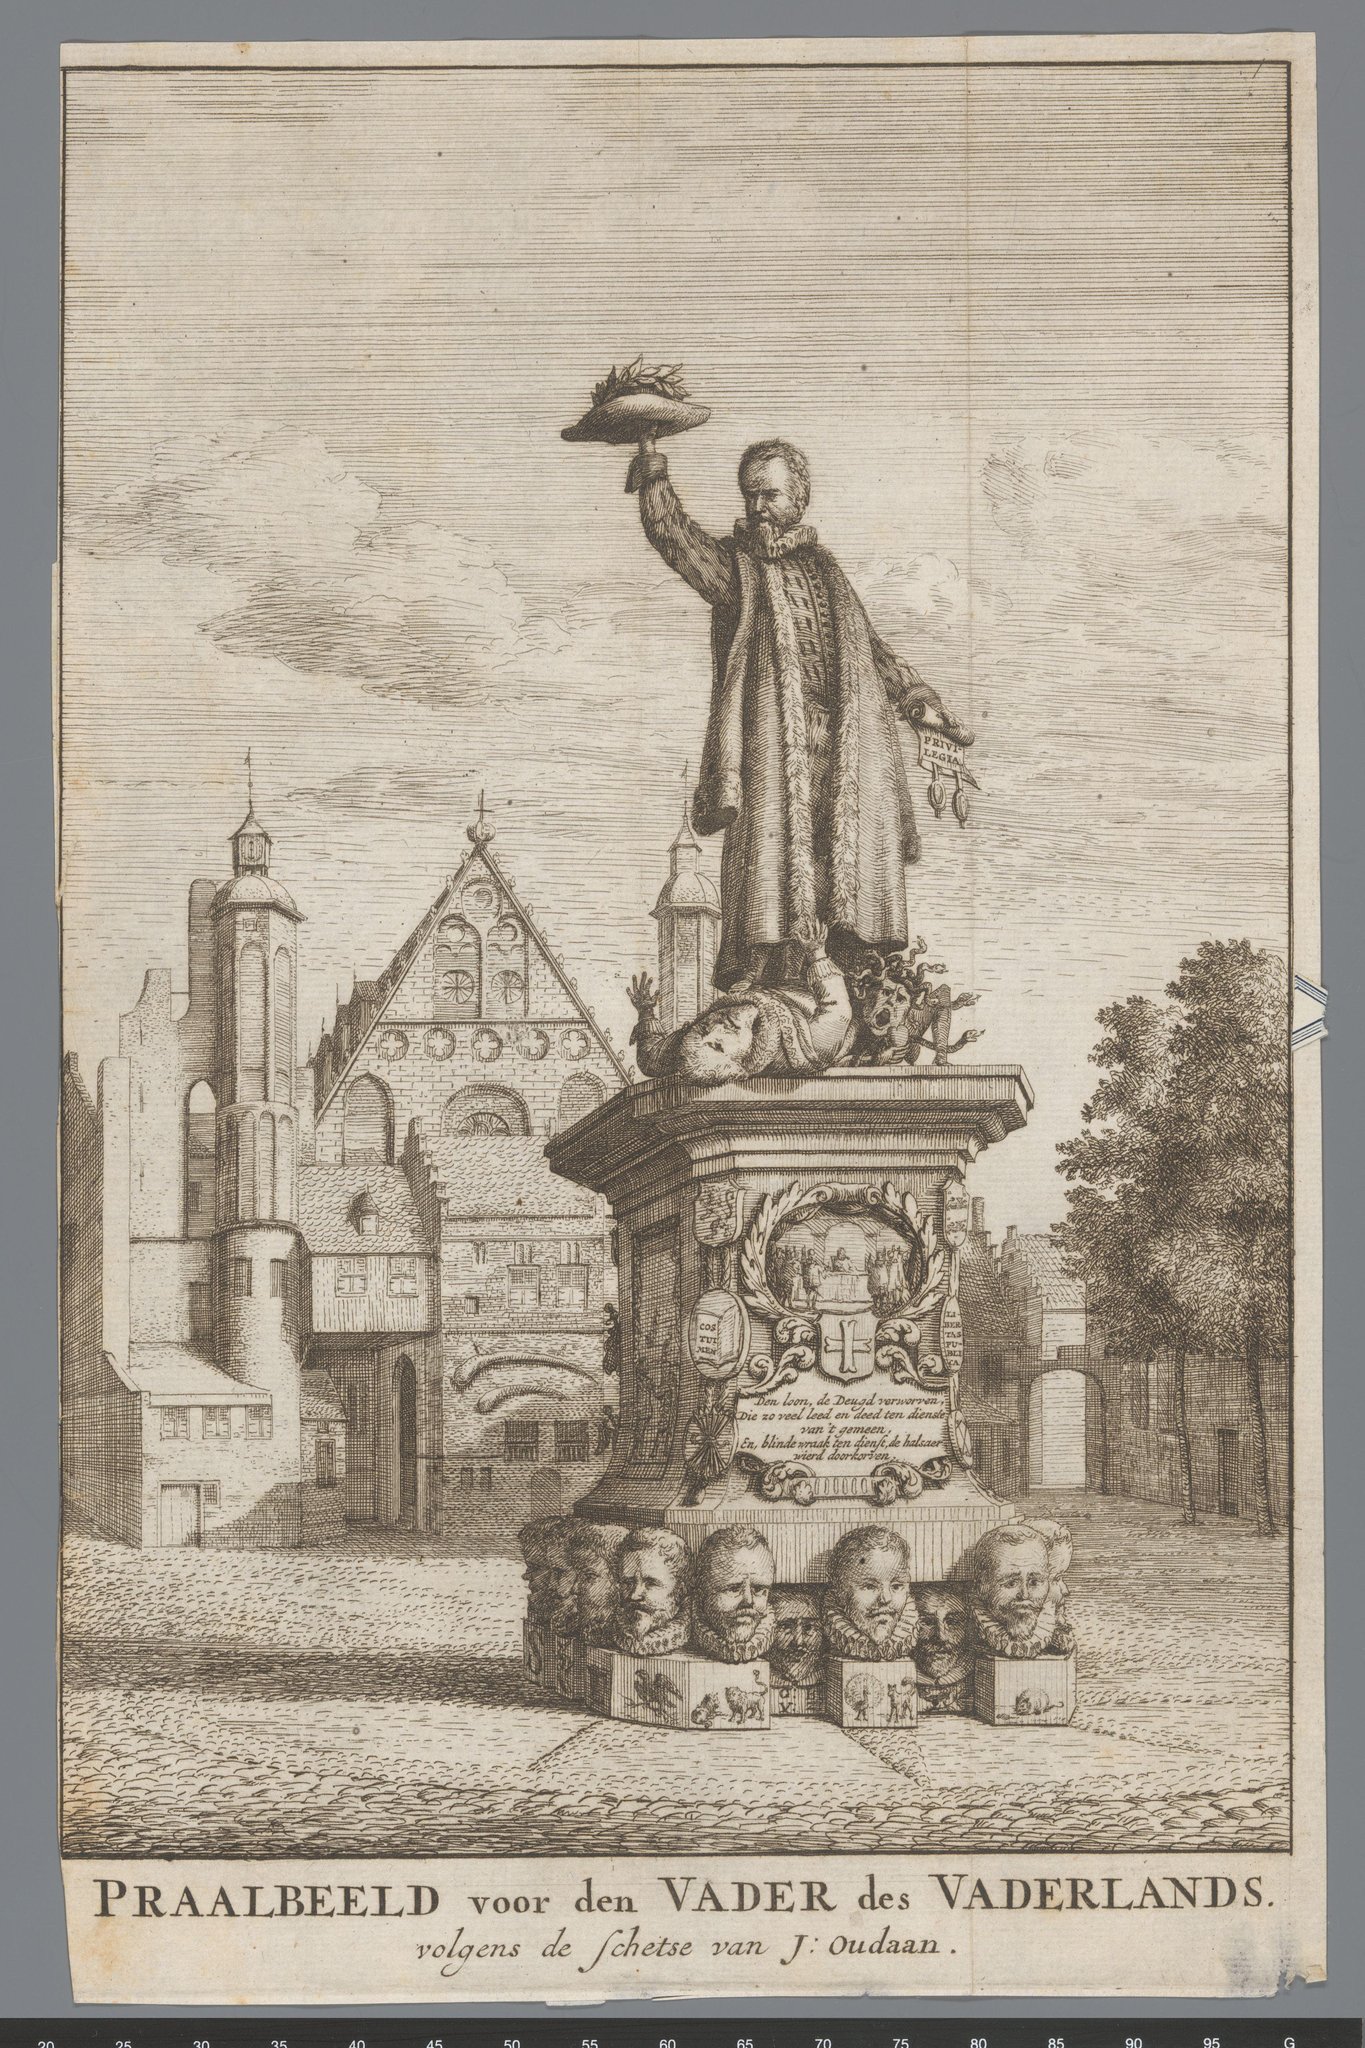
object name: print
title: Allegorisch standbeeld voor Johan van Oldenbarnevelt, terechtgesteld in 1619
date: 1708-1710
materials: paper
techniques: etching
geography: northern netherlands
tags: the hague, johan van oldenbarnevelt, maurice (prince of orange), piece of sculpture, reproduction of a piece of sculpture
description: Allegorisch standbeeld voor Johan van Oldenbarnevelt, gestorven 13 mei 1619. De landsadvocaat met vrijheidshoed en privilege in de hand, staande in triomf op prins Maurits en de personificatie van de Afgunst. Op het voetstuk een vers, het beeld rustend op de hoofden van de 24 rechters die Van Oldenbarnevelt ter dood veroordeeld hebben met de hierbij corresponderende dieren. Op het grote plein van het Binnenhof.